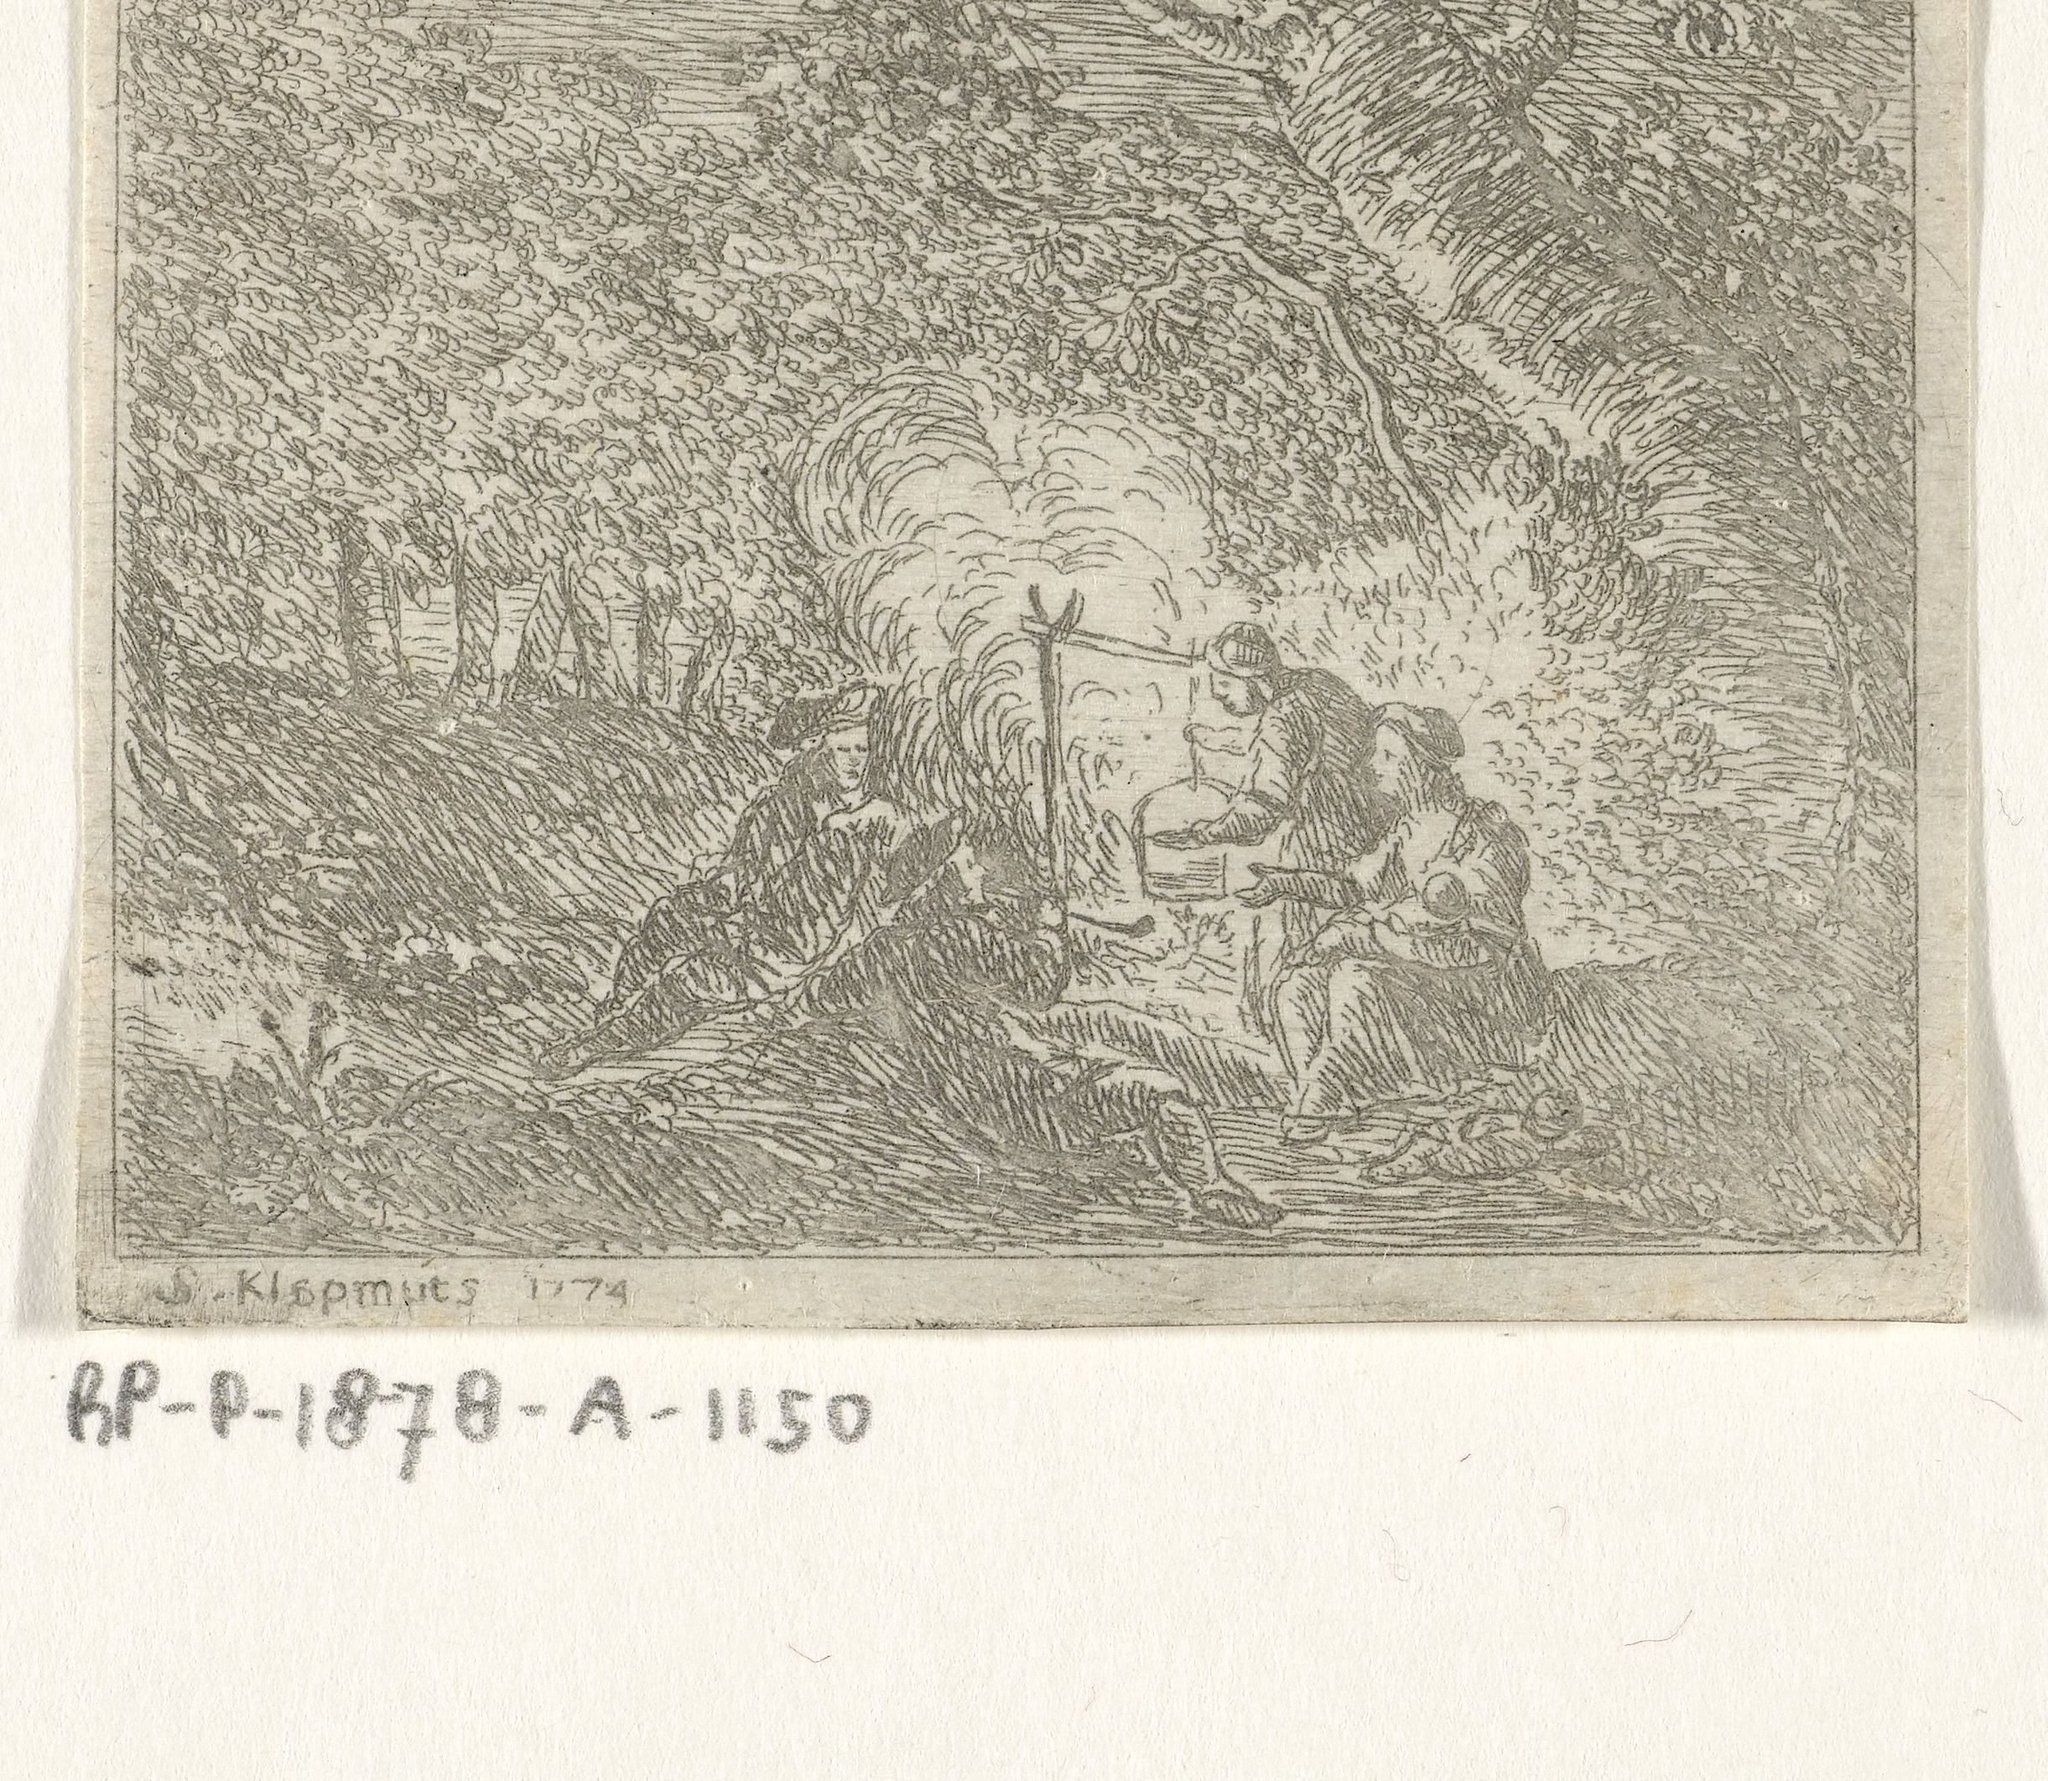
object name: print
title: Gezelschap rond een kampvuur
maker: simon klapmuts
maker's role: print maker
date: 1774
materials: paper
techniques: etching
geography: moordrecht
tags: adult man, pipe ~ tobacco, forest, wood, camp-fire; watch-fire, mother and baby or young child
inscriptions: collector's mark: Lugt 2227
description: In een bos aan de voet van een grote boom bevinden zich twee vrouwen en twee mannen in 18e-eeuwse kleding bij een vuur waarboven een ketel hangt.